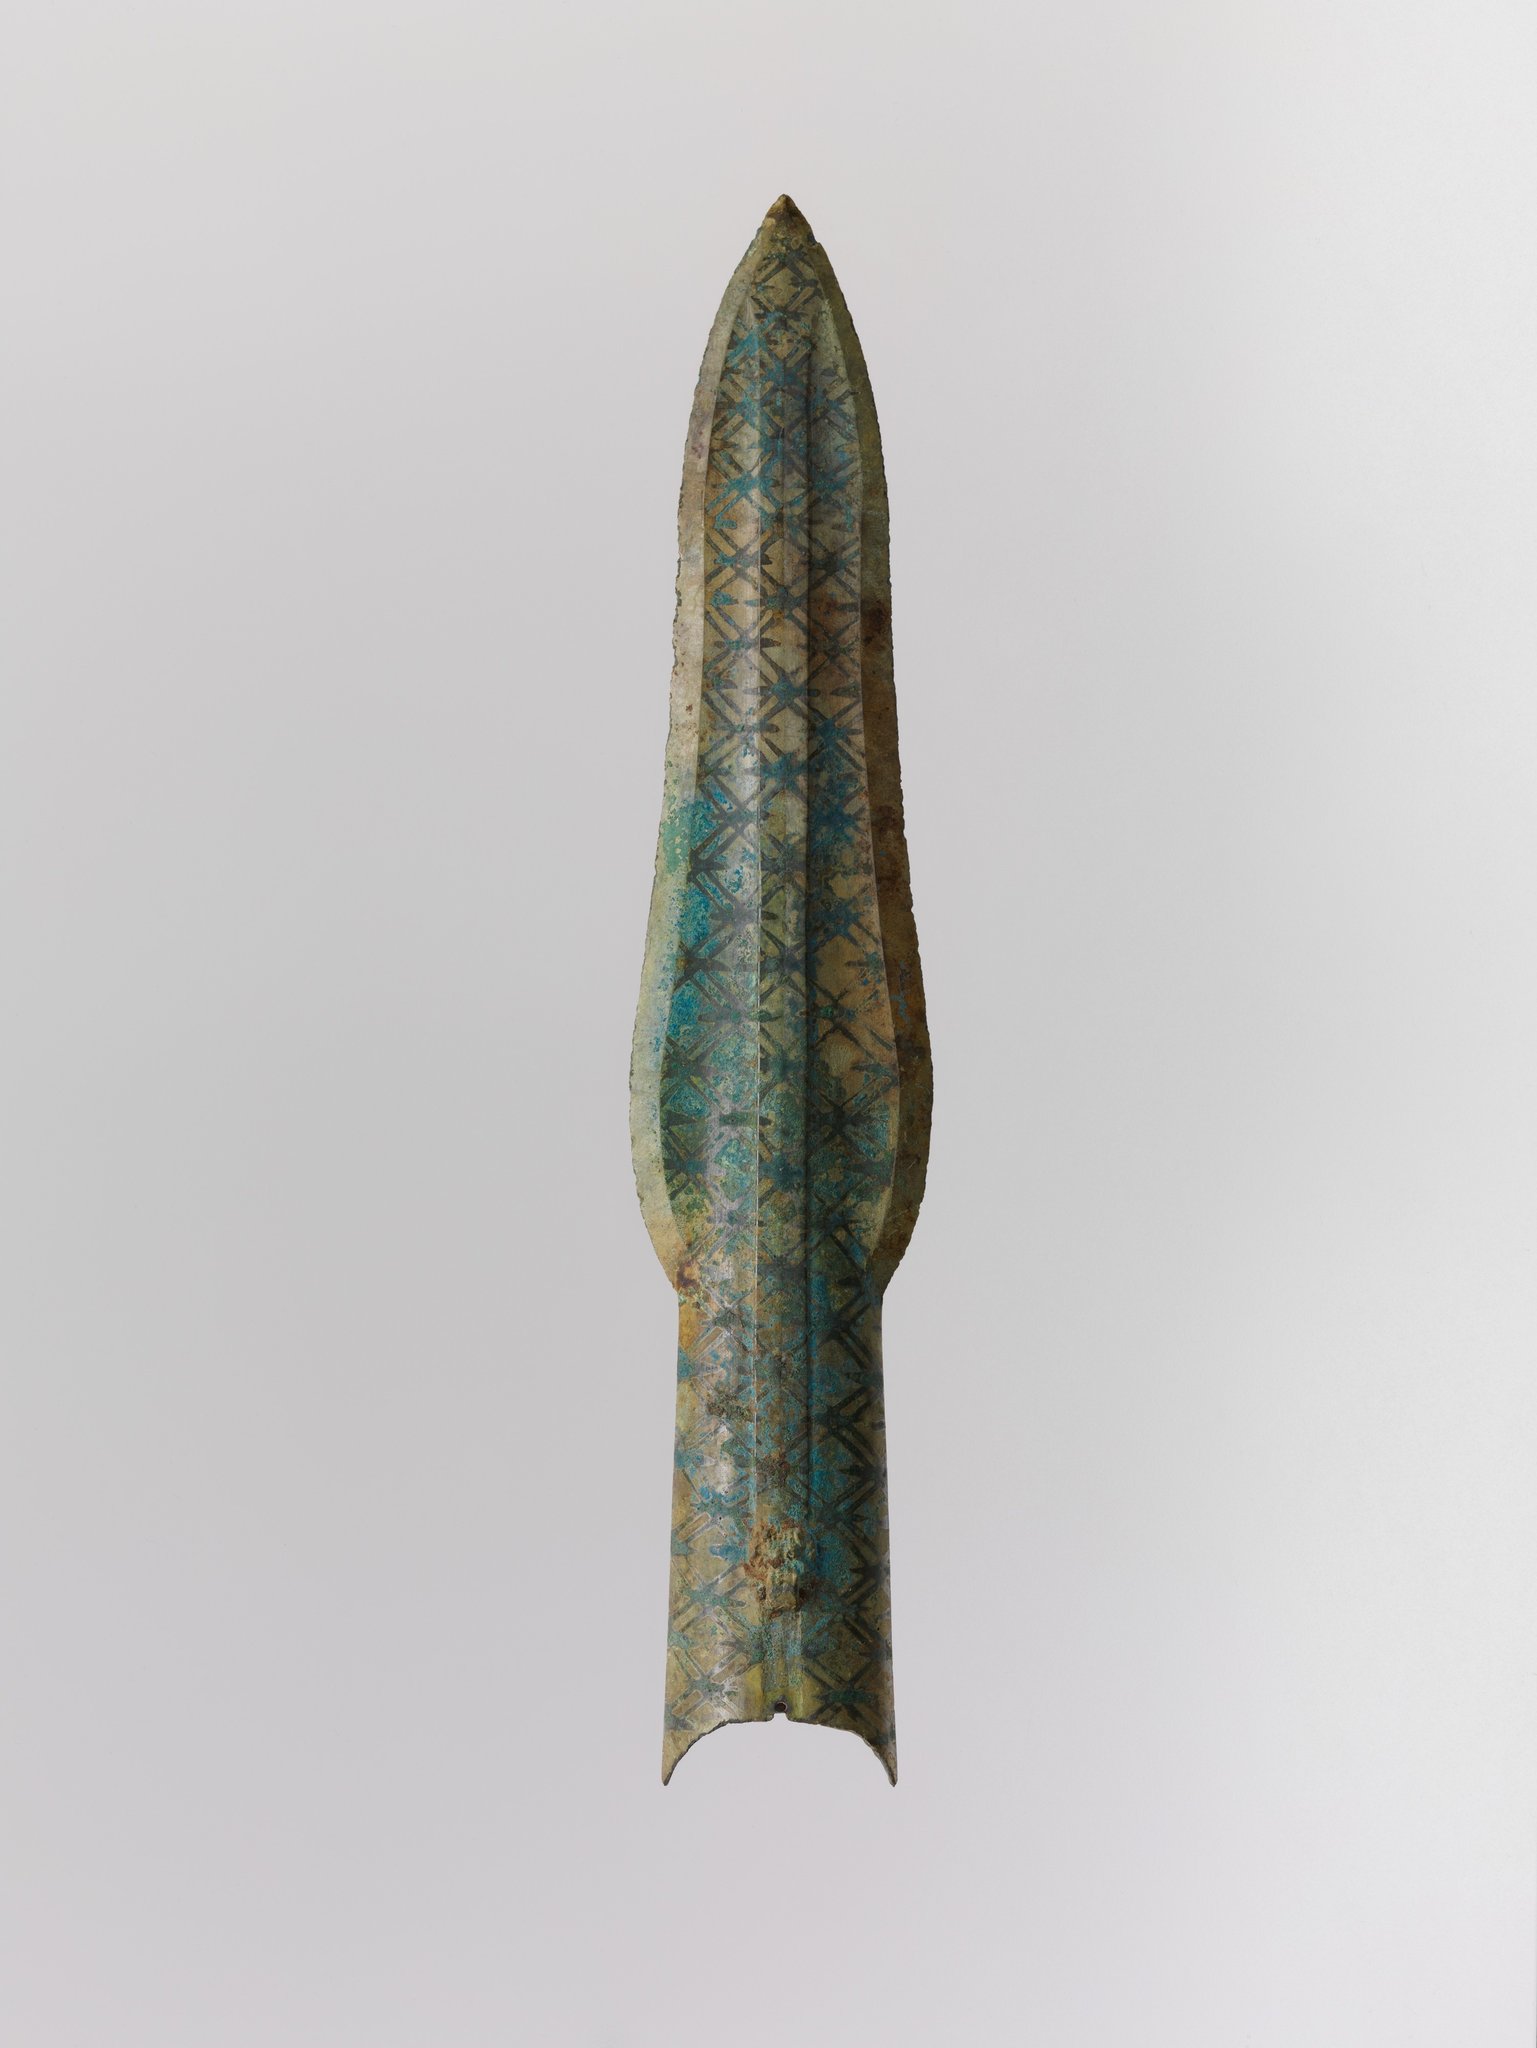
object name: spear head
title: Spear head (mao)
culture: chinese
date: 600-301 BCE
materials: bronze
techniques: inlay